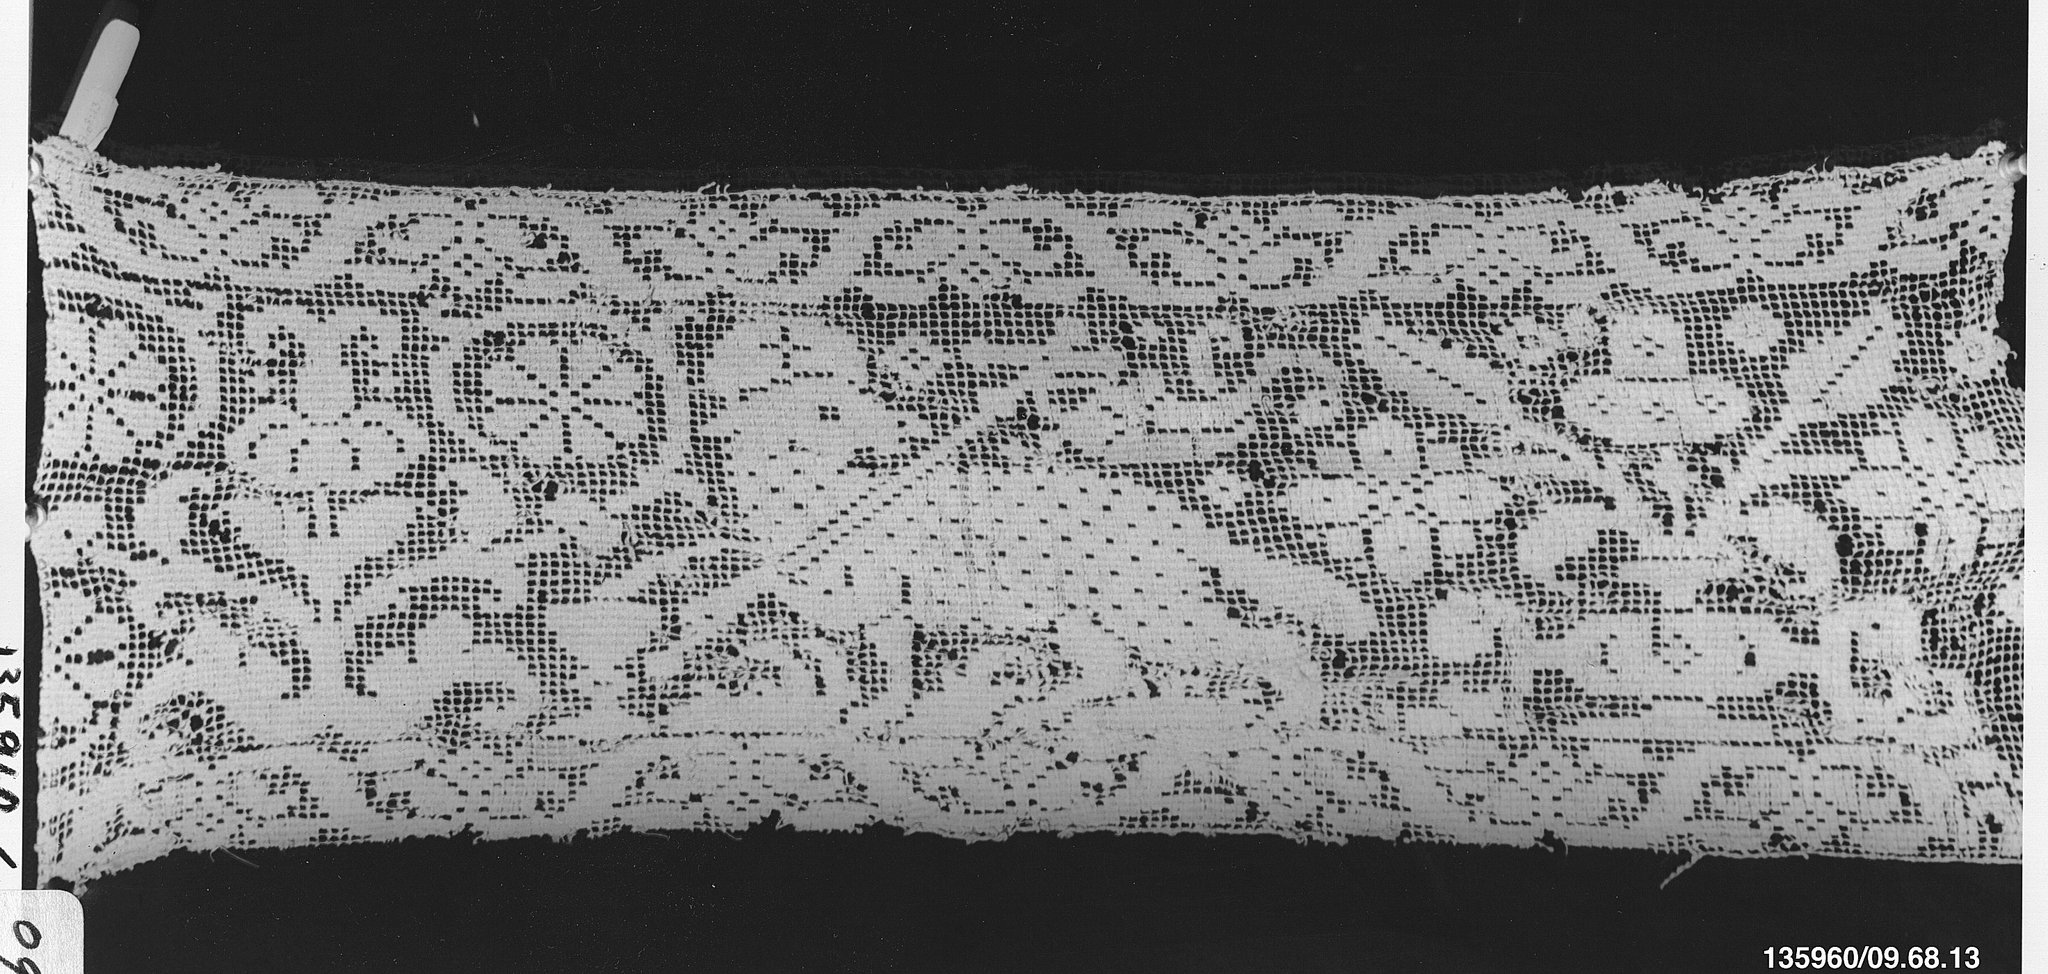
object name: border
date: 1601-1700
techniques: embroidery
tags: animals